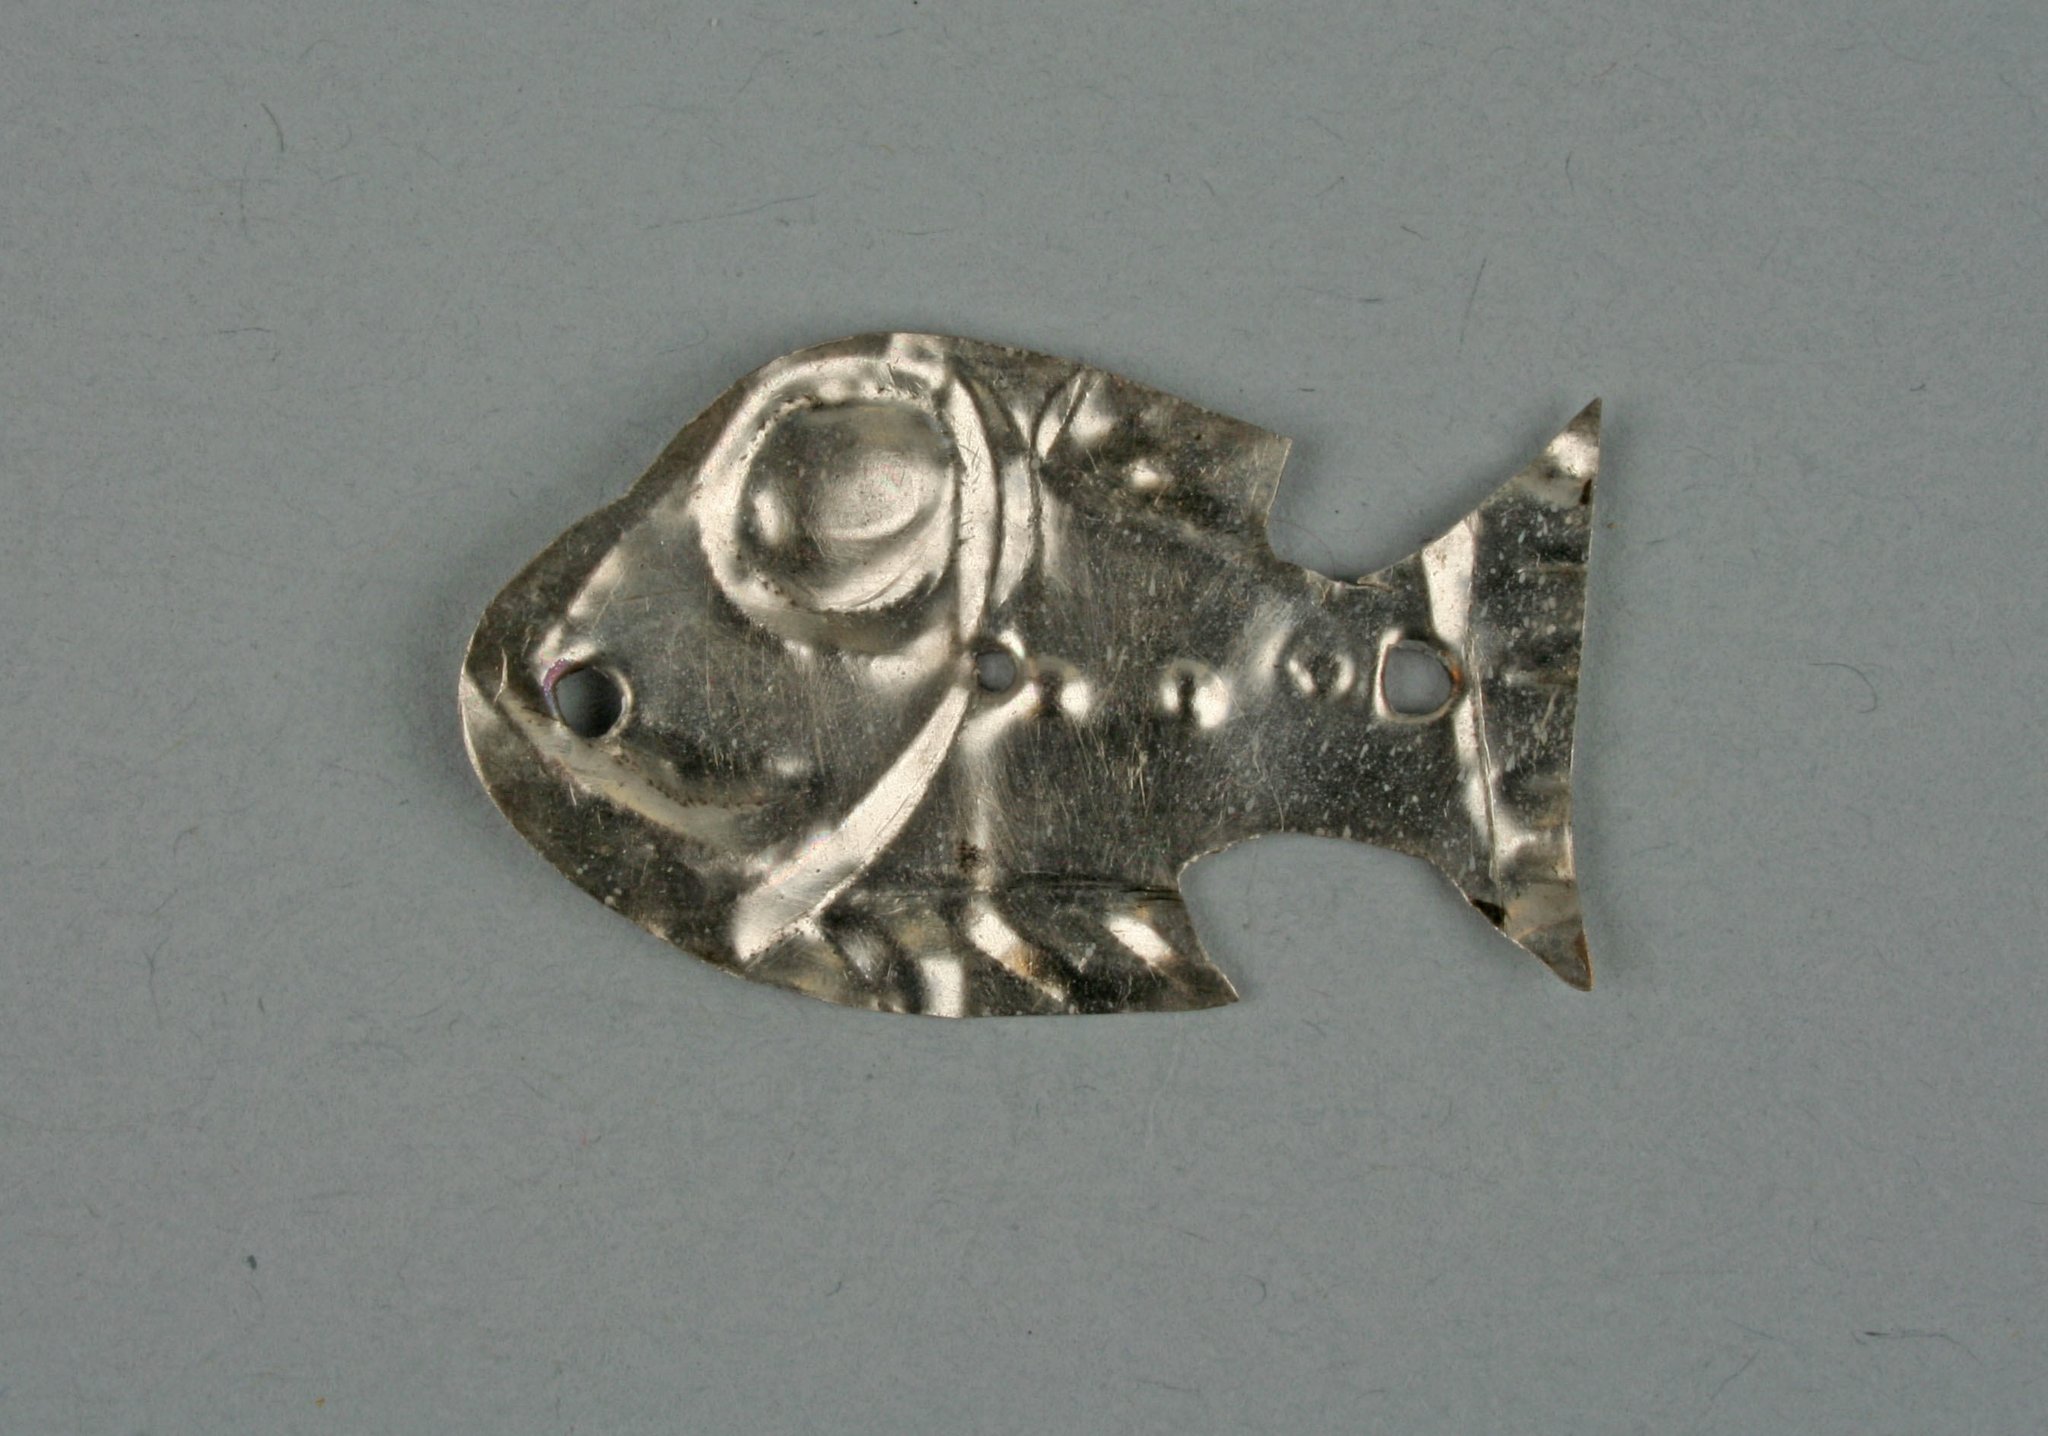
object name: ornament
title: Fish Ornament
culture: peruvian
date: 1001-1200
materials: silver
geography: peru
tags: fish